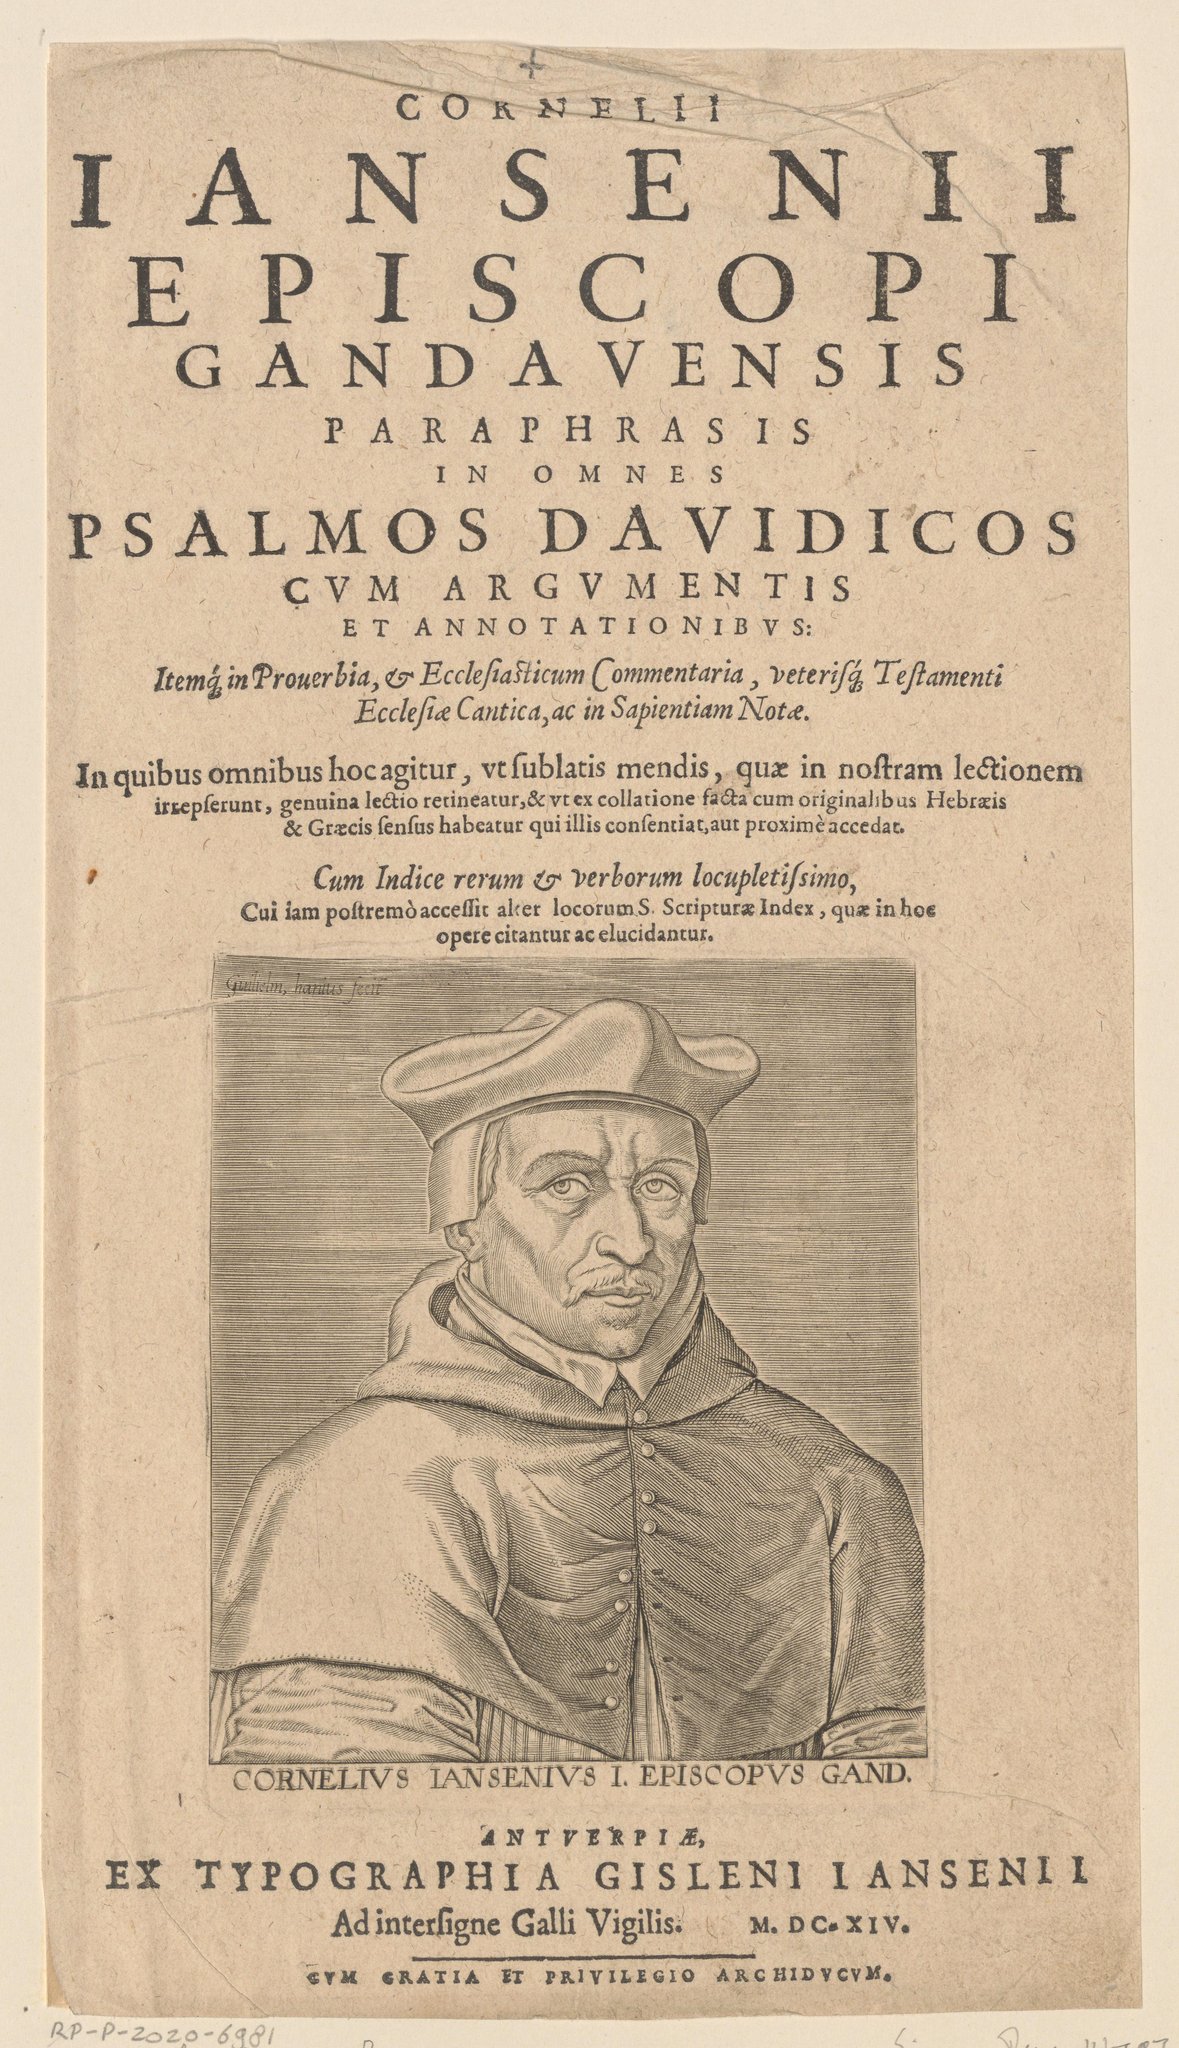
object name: print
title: Titelpagina voor: Cornelius Jansenius, Cornelii Iansenii episcopi Gandavensis (...), 1614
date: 1614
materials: paper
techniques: engraving, letterpress printing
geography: antwerp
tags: cornelius jansenius, archbishop, bishop, etc. (roman catholic), historical persons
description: Titelpagina voor: Jansenius, Cornelius. Cornelii Iansenii episcopi Gandavensis (...), Antwerpen: Gheleyn Janssens, 1614.